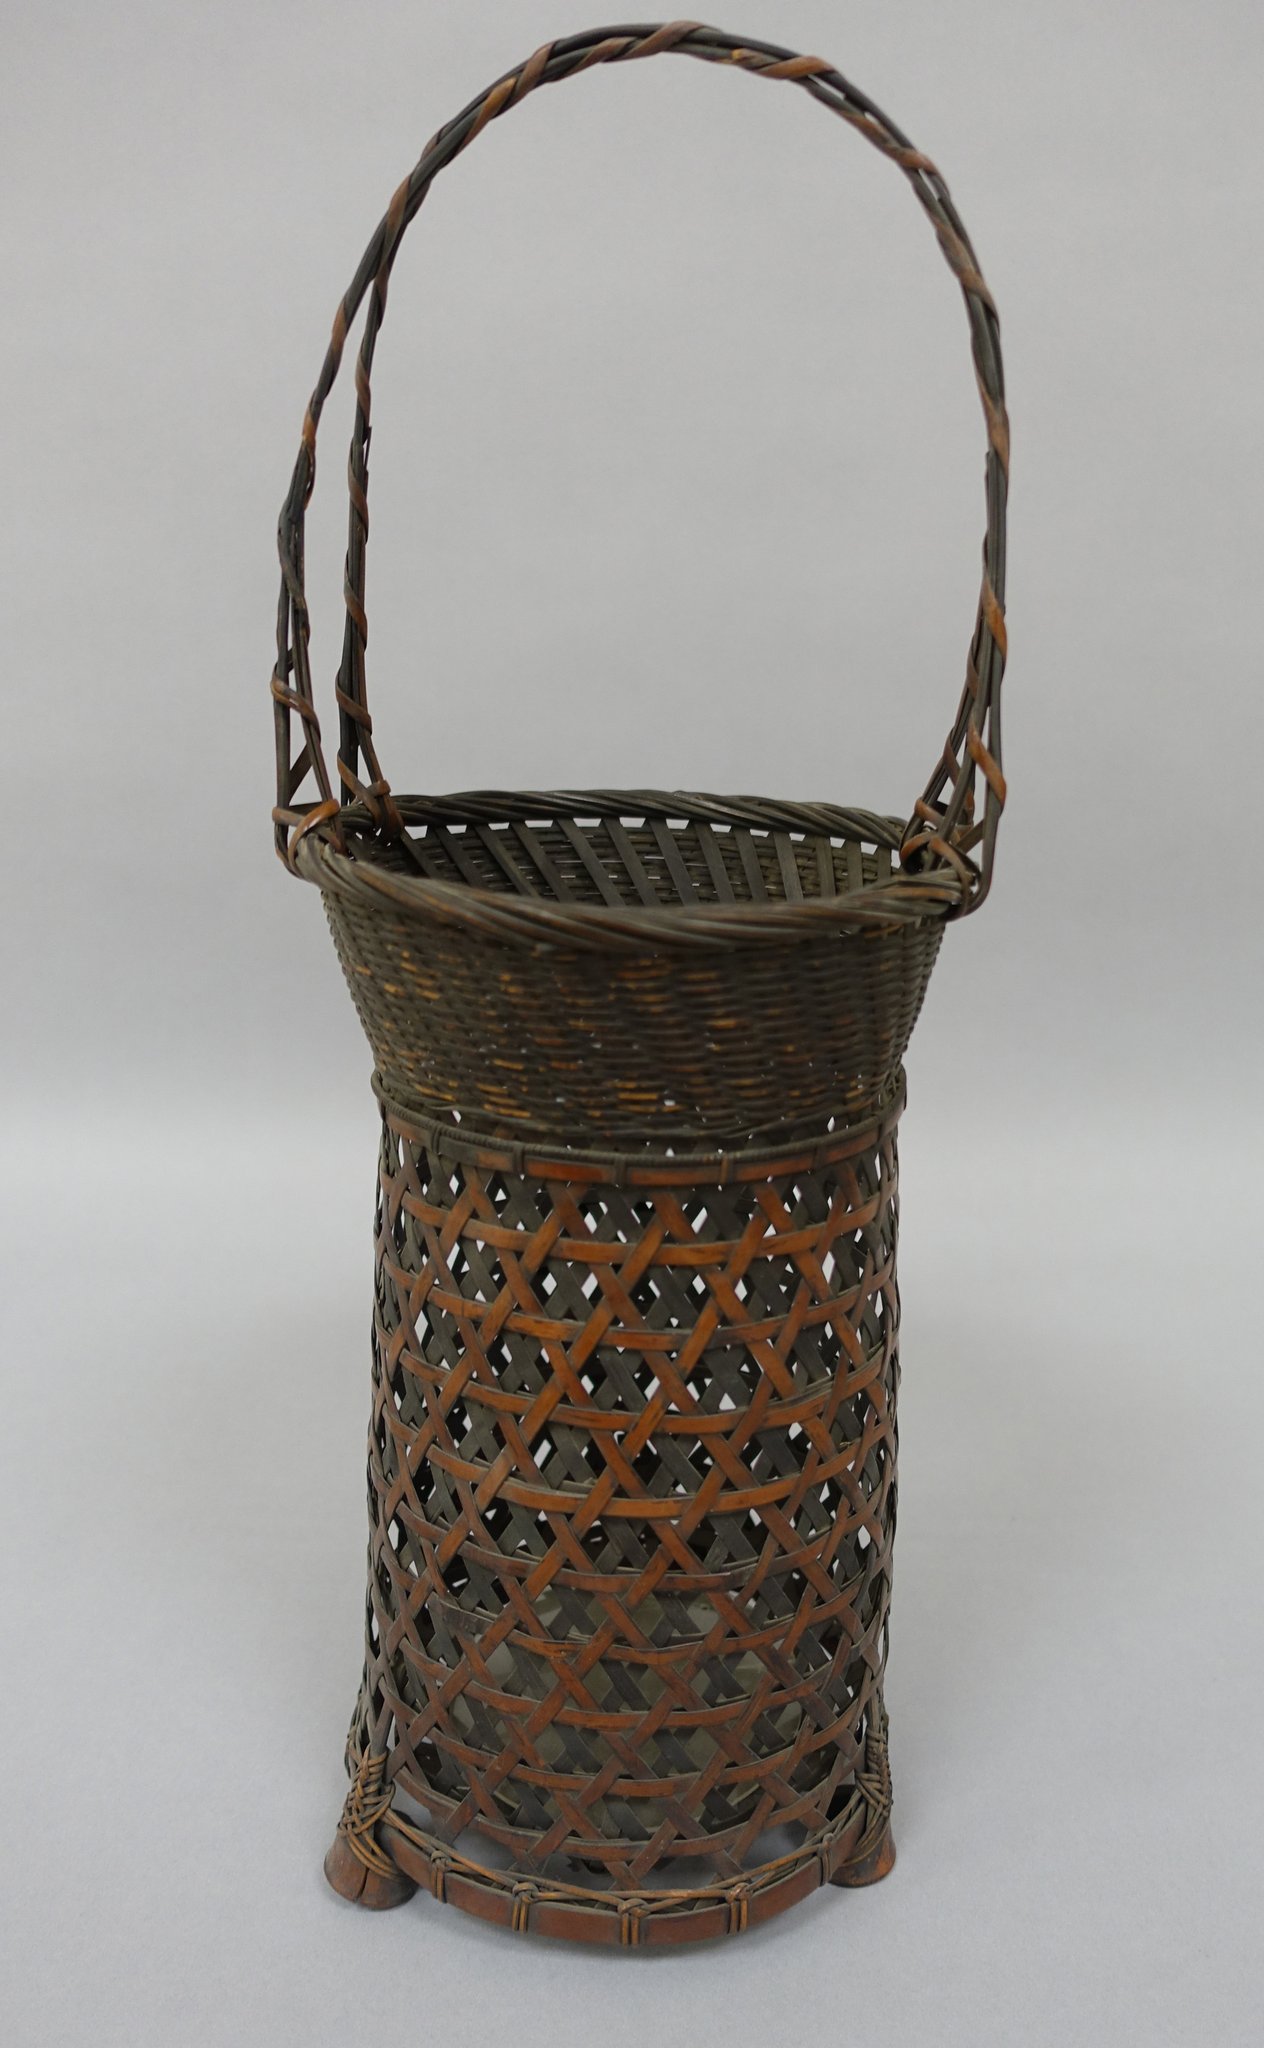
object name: basket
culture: japanese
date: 1801-1900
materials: bamboo